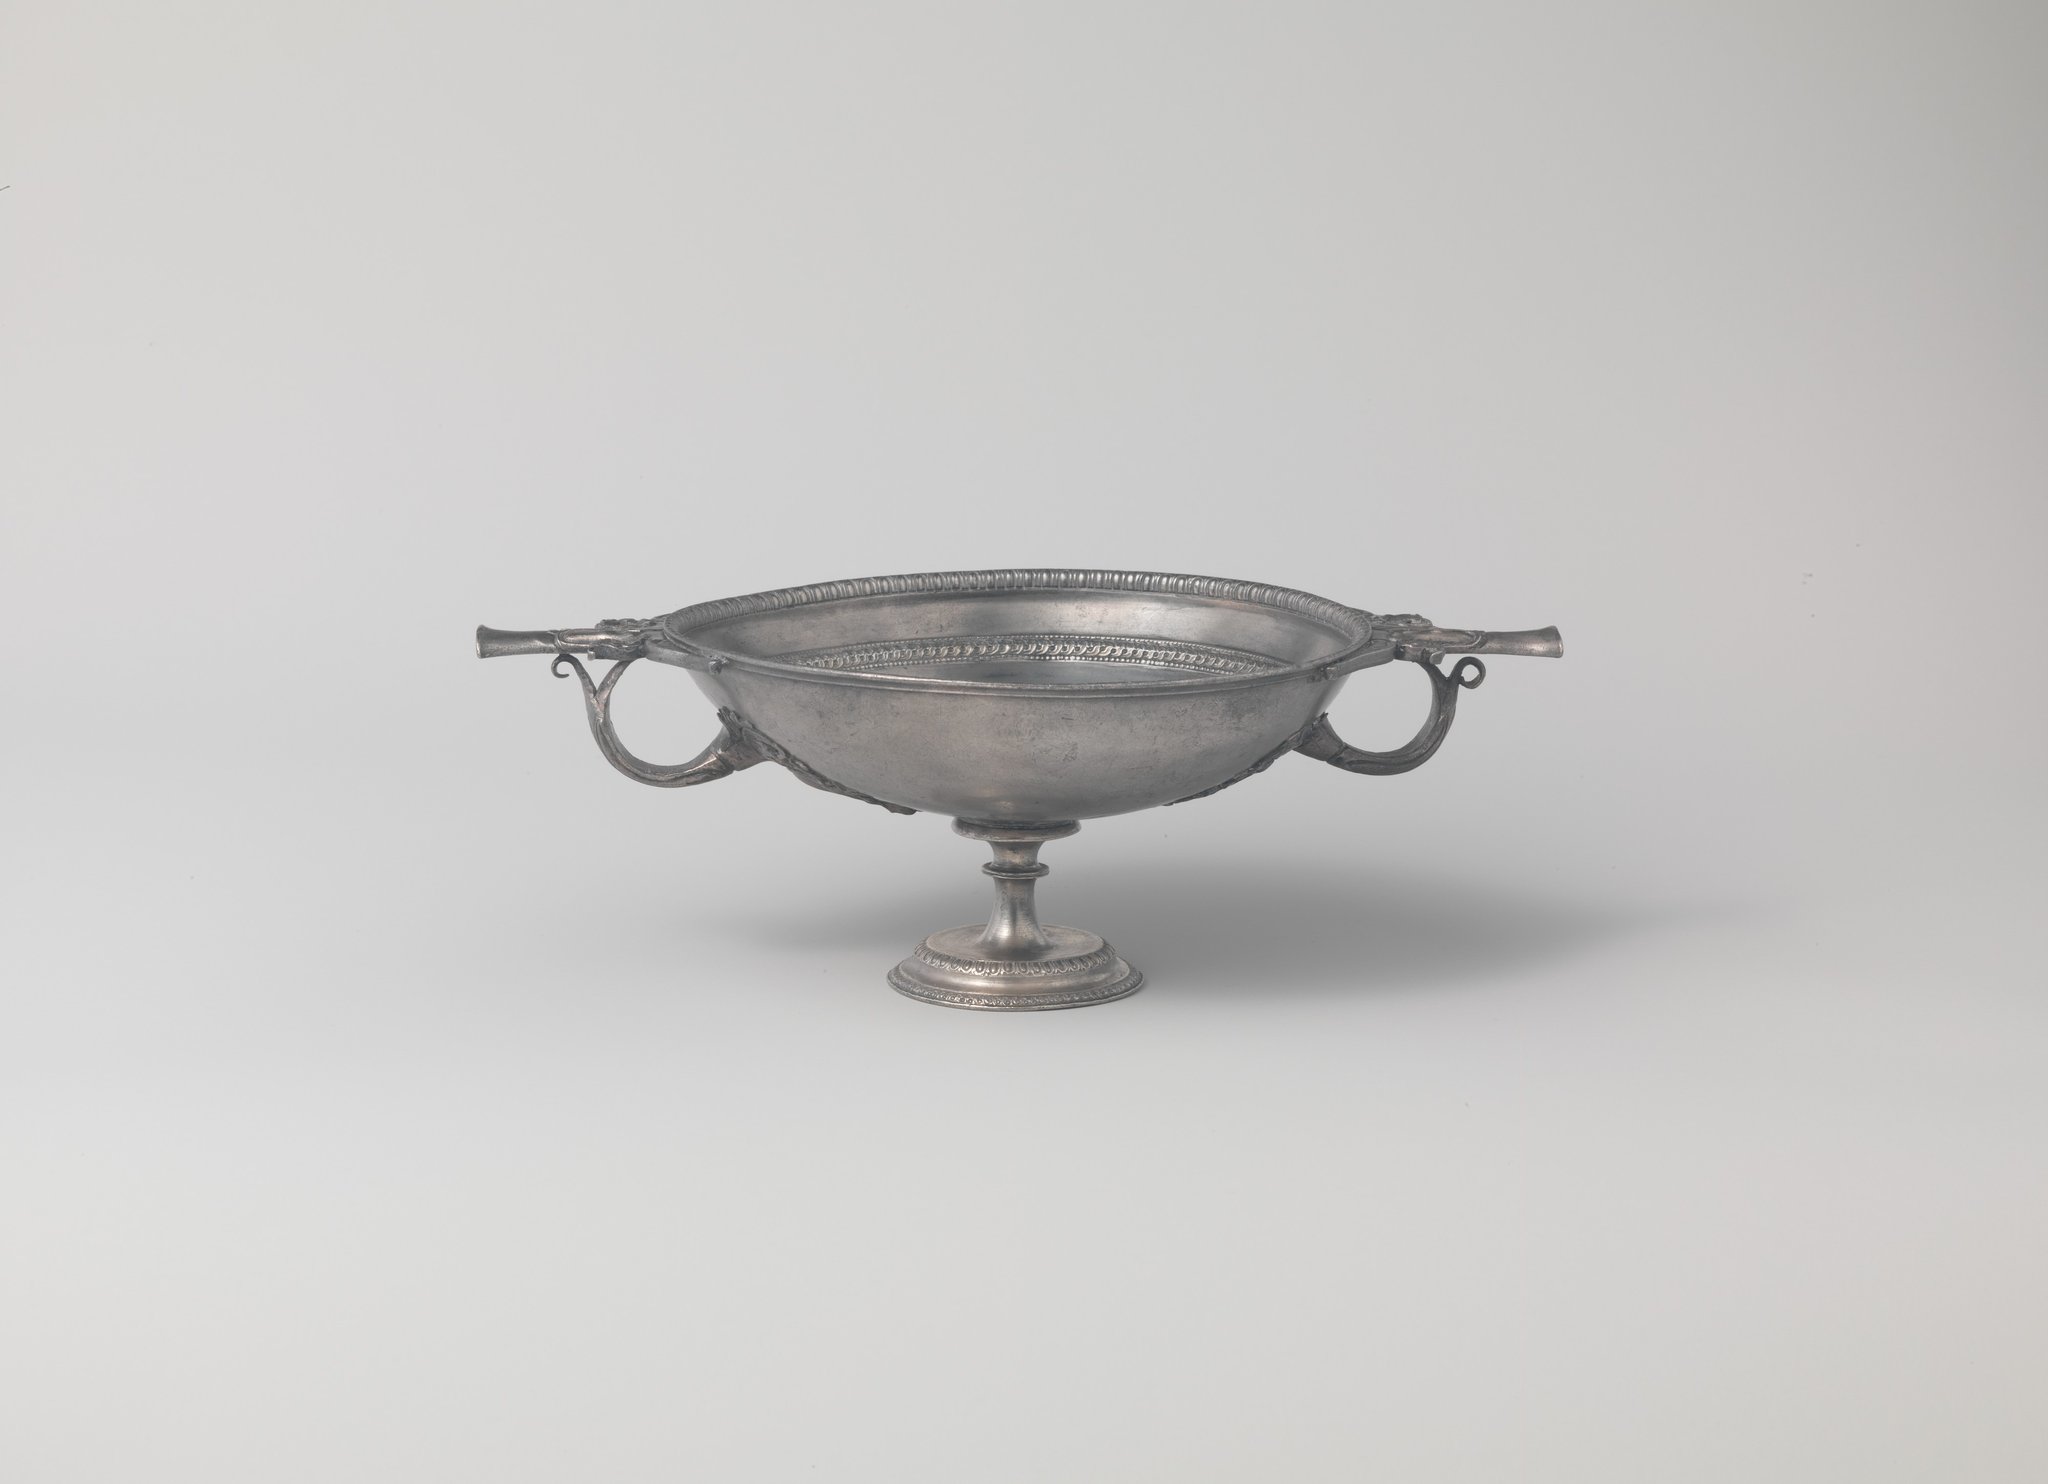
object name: kylix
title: Silver drinking cup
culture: roman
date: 100 BCE-100 CE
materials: gold, silver